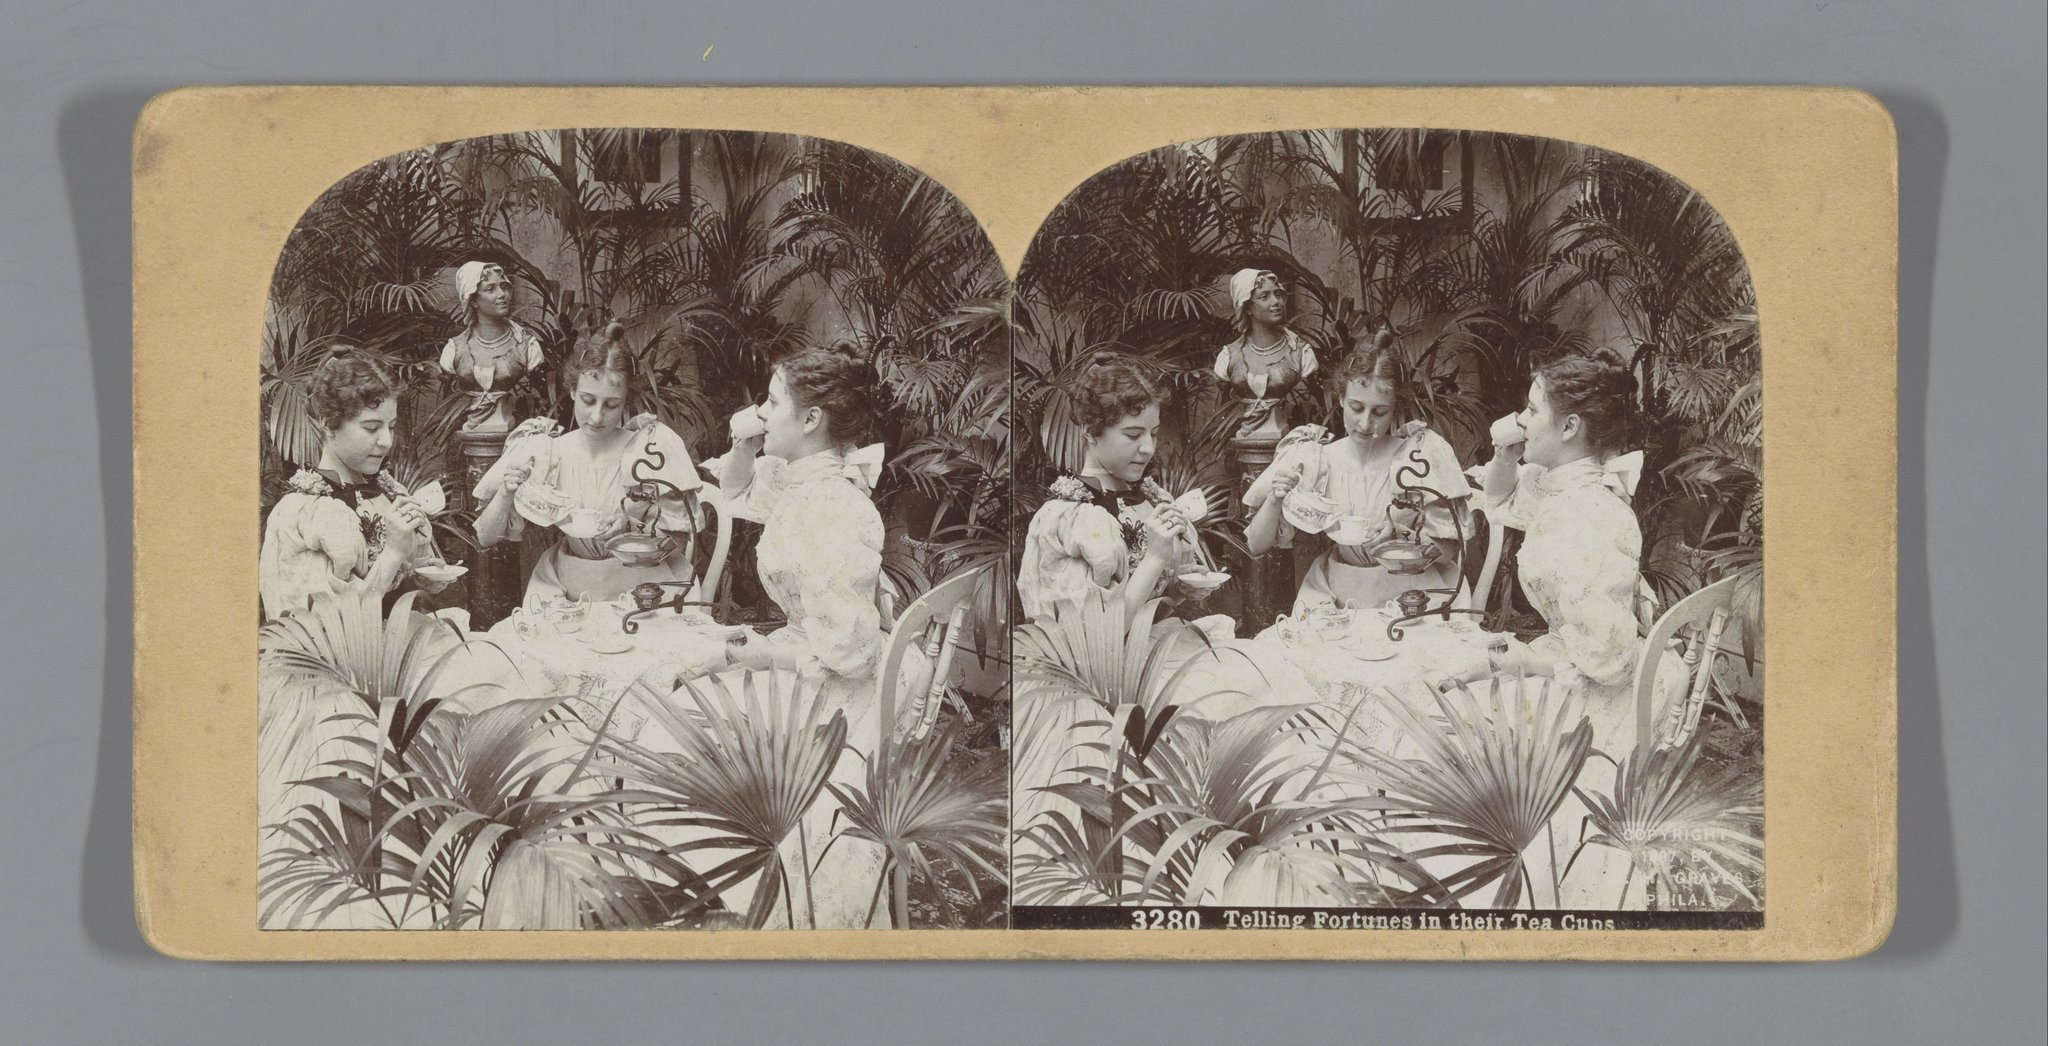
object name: stereograph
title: Drie theedrinkende vrouwen rond tafel in ruimte met planten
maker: carleton harlow graves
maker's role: fotograaf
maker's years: 1867-1943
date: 1897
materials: cardboard, photographic support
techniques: gelatin silver print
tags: tea-ceremony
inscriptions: number: ‘3280’, name: ‘Copyright 1897, by C.H. Graves / Phila.’